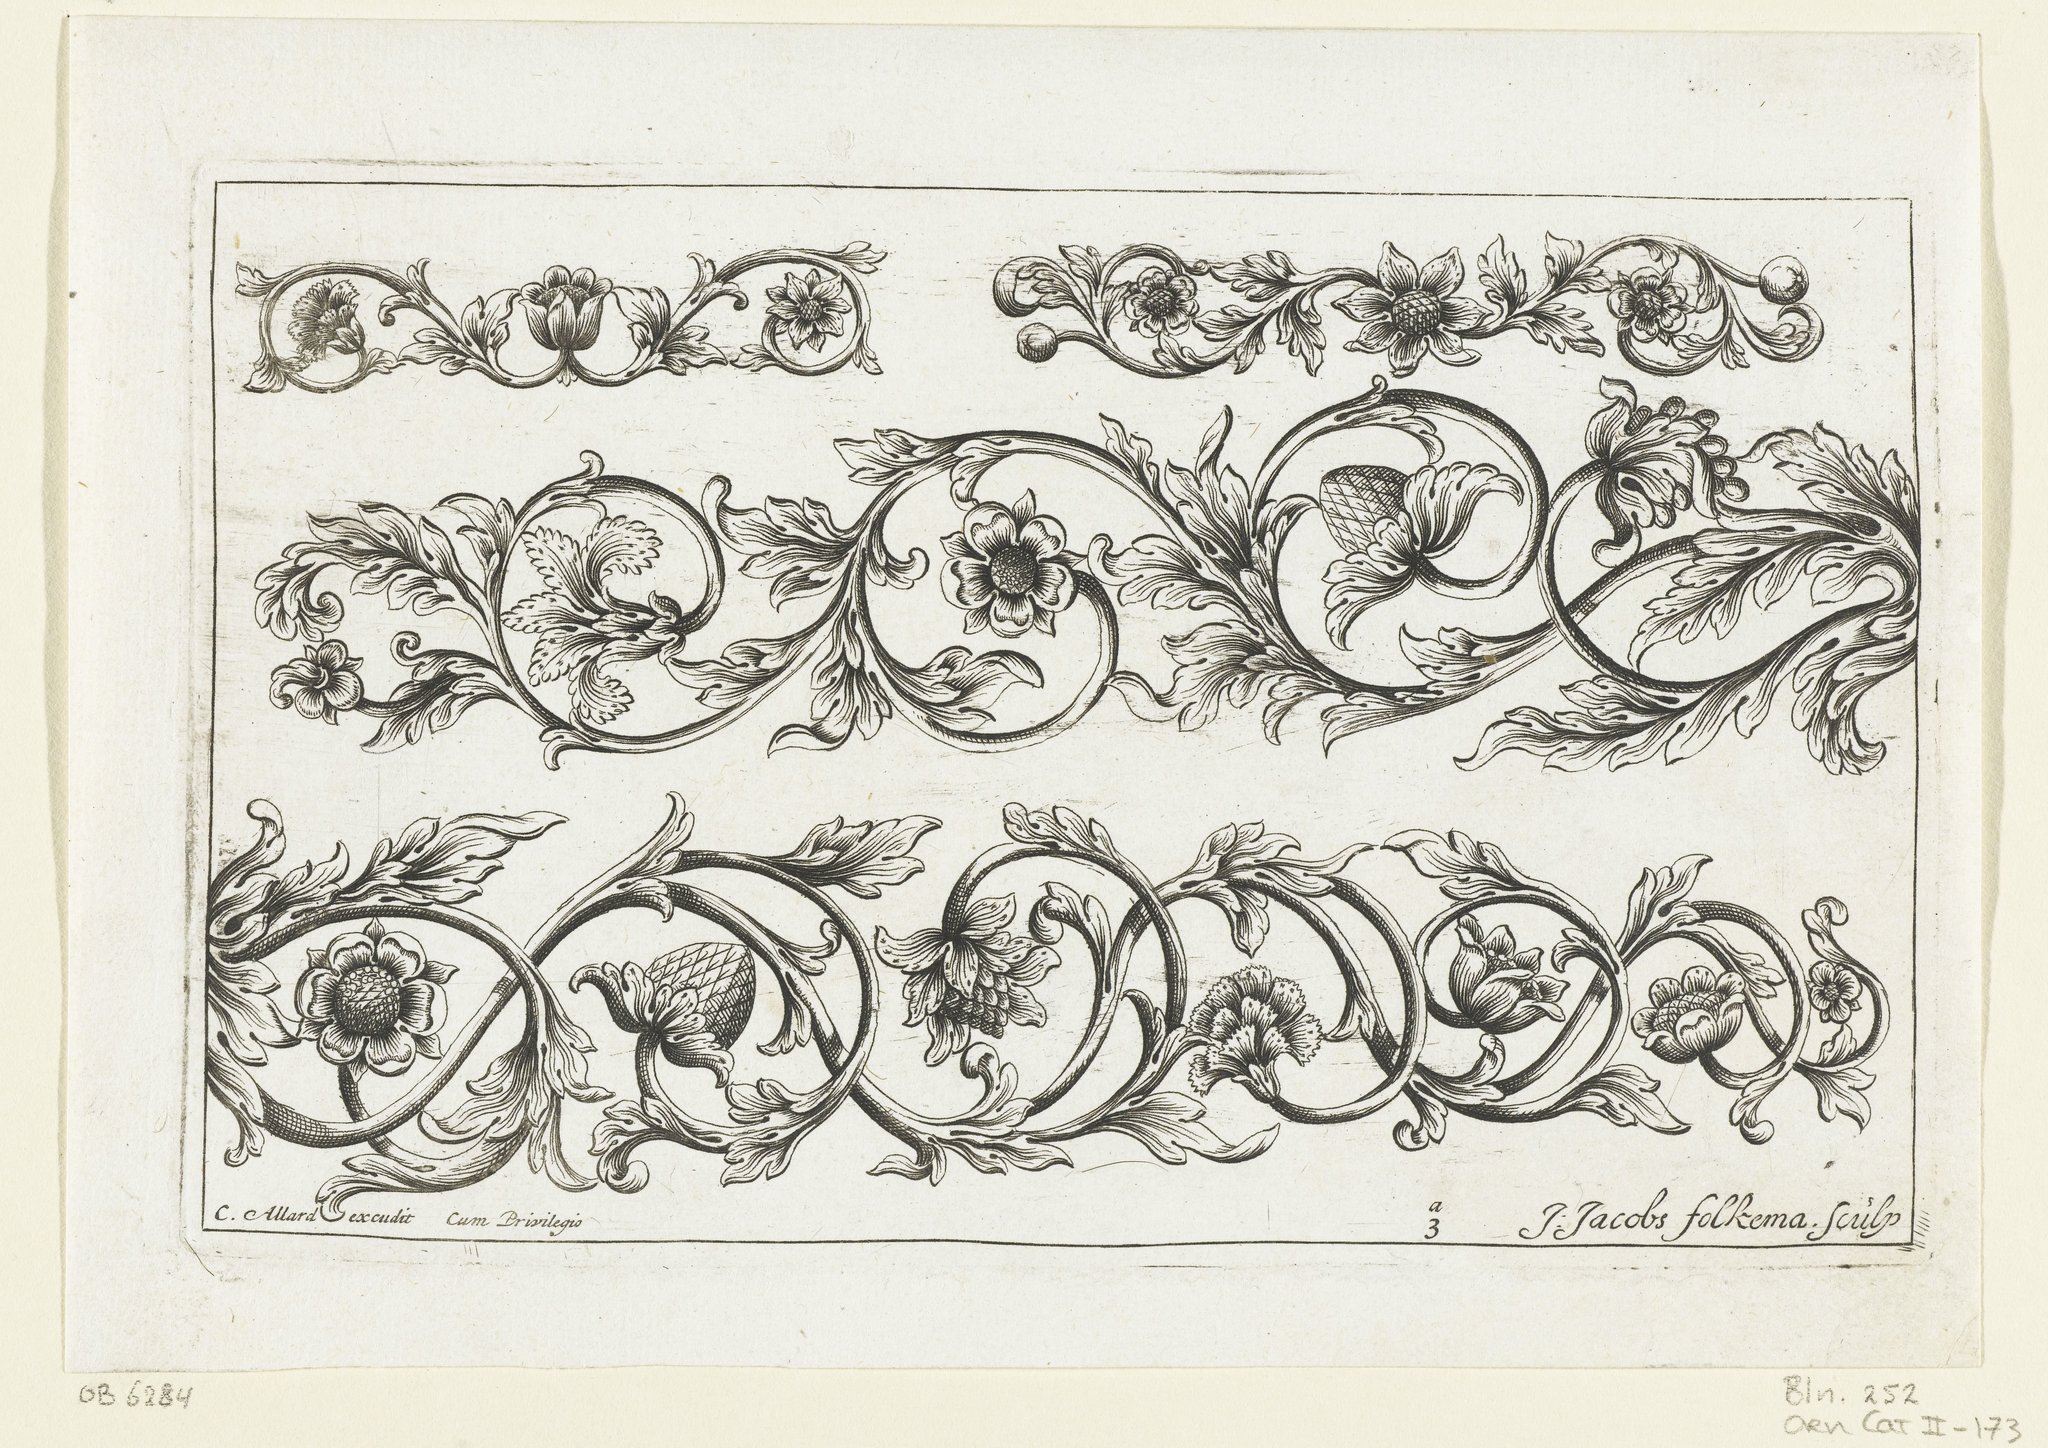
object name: print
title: Alderhande Voorbeelden van Doorgebroken Zilver-Smids Werk (...)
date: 1690-1700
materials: paper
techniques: engraving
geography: amsterdam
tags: ornament derived from plant forms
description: Uit serie van 6 bladen met voorbeelden van ornamenten voor zilversmeden.